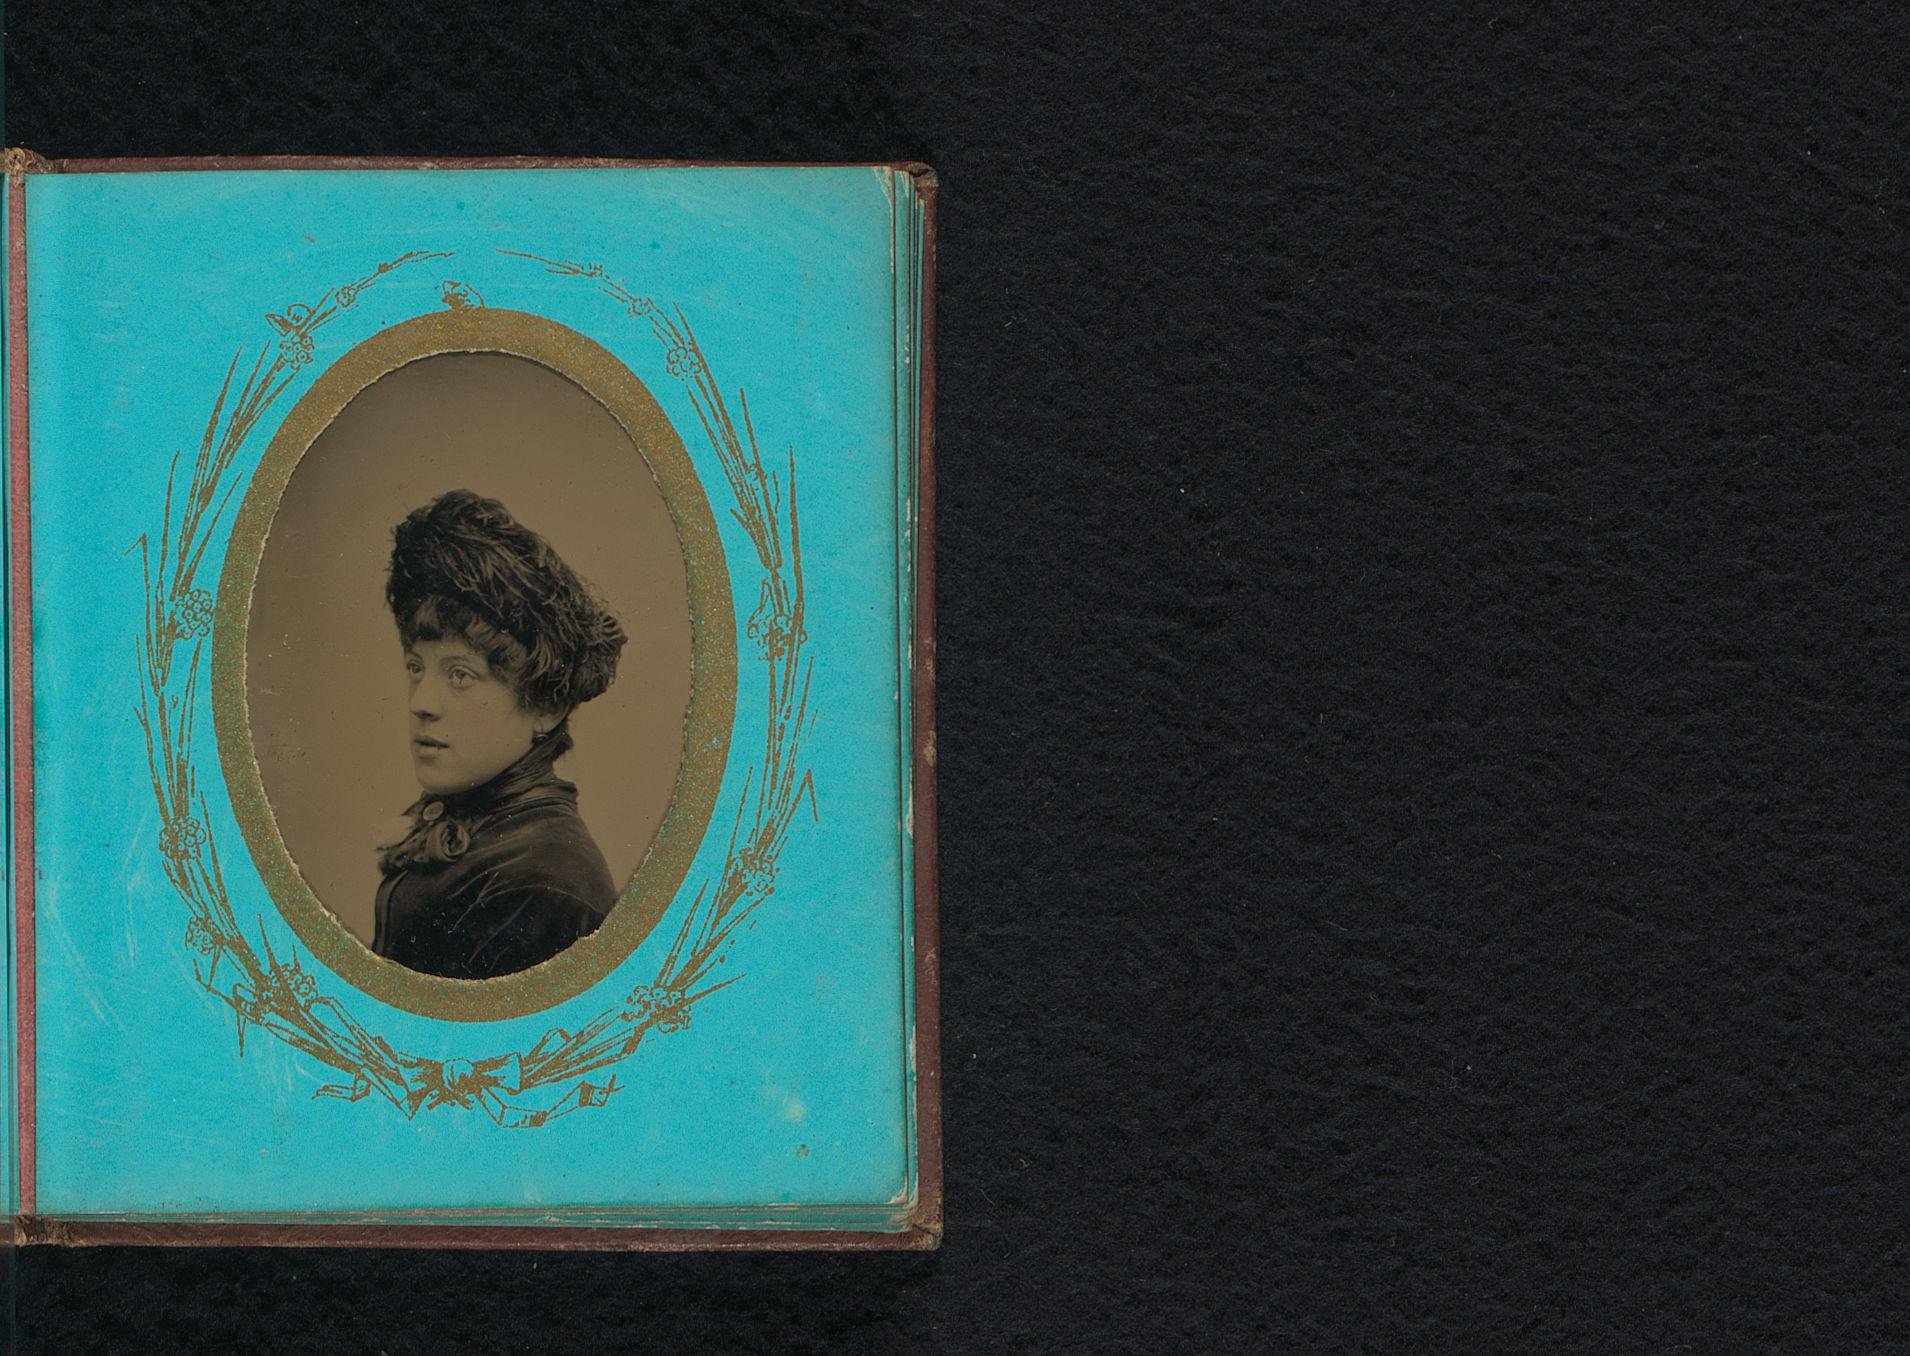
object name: photograph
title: Portret van een vrouw met hoed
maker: Anonymous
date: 1880-1900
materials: iron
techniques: ferrotyping, hand coloring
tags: historical persons not known by name - bb - woman, head-gear: hat